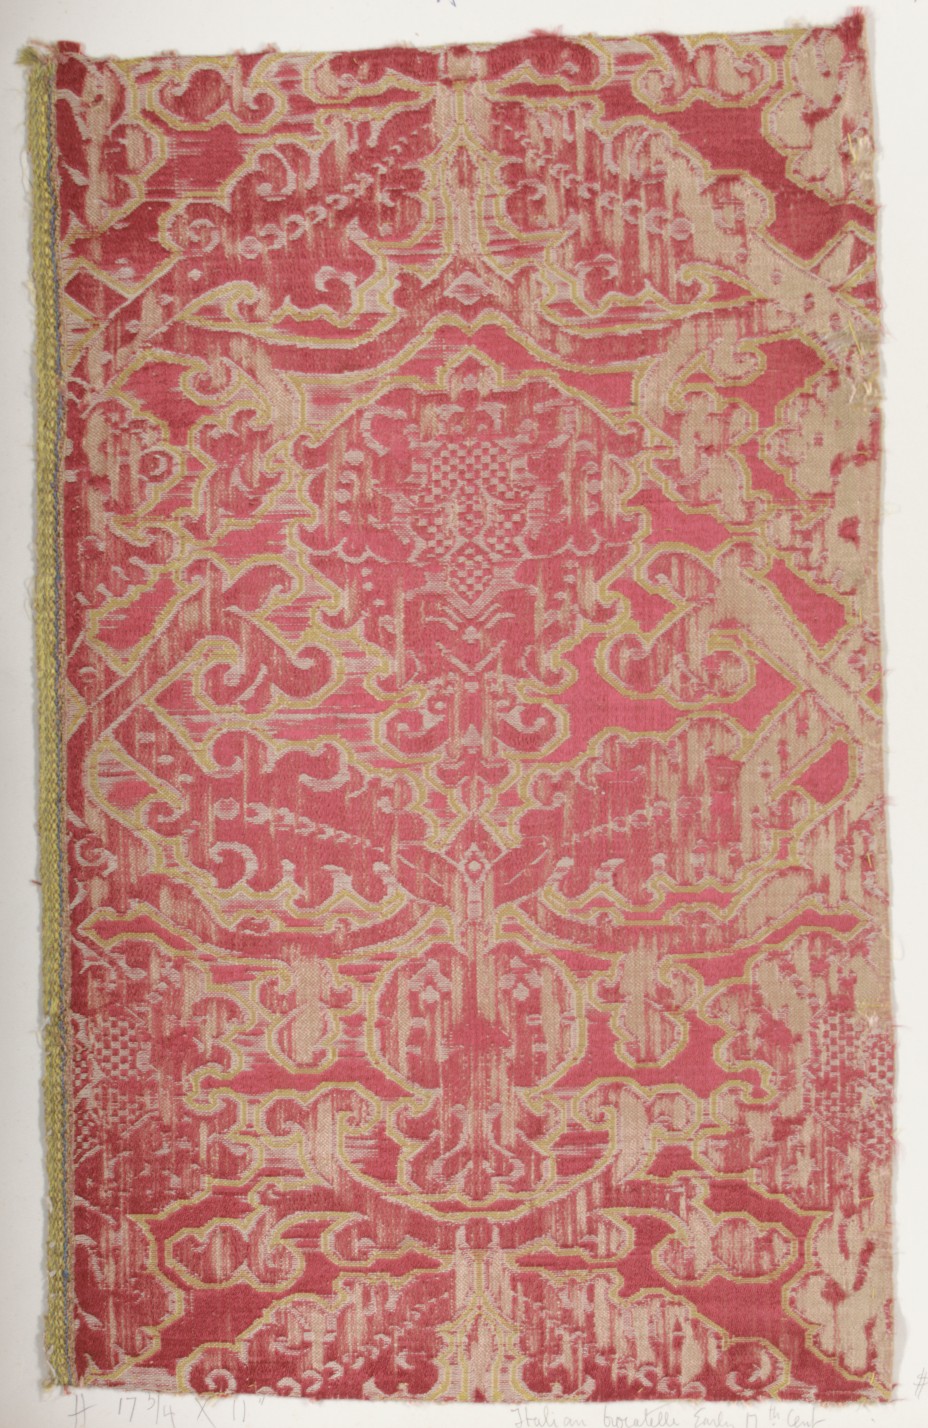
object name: fragment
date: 1601-1633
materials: silk